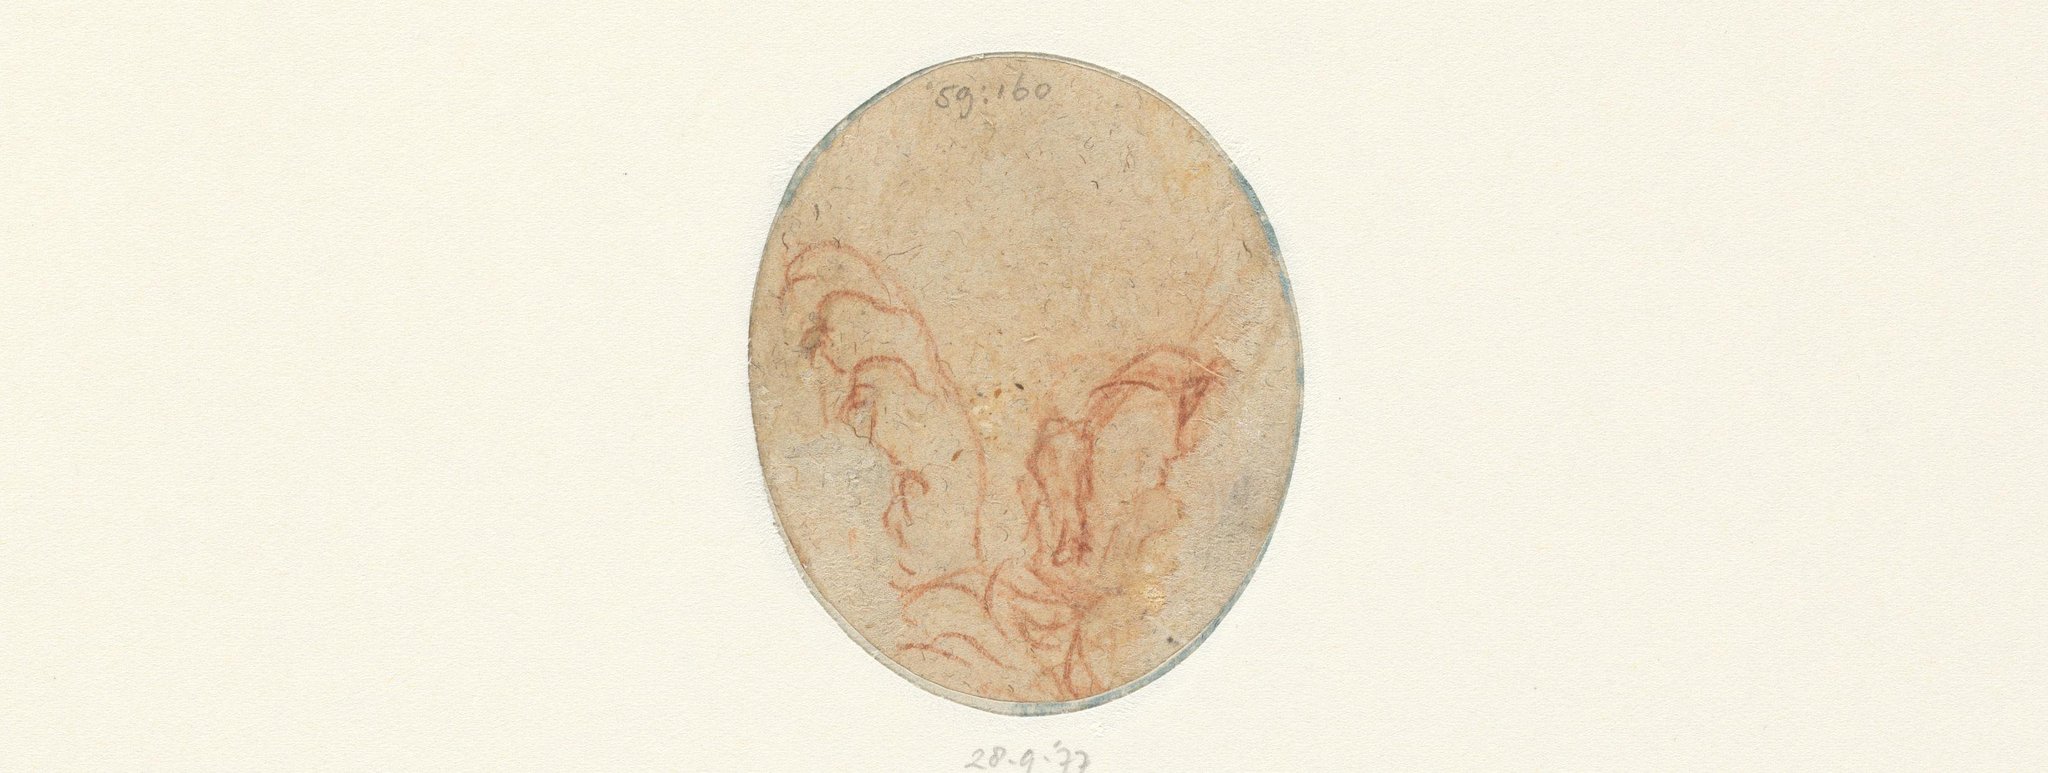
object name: drawing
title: Voorpoot van een leeuw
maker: jacques de gheyn (ii)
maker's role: painter, print maker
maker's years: 1565-1629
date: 1575-1625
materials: paper, chalk